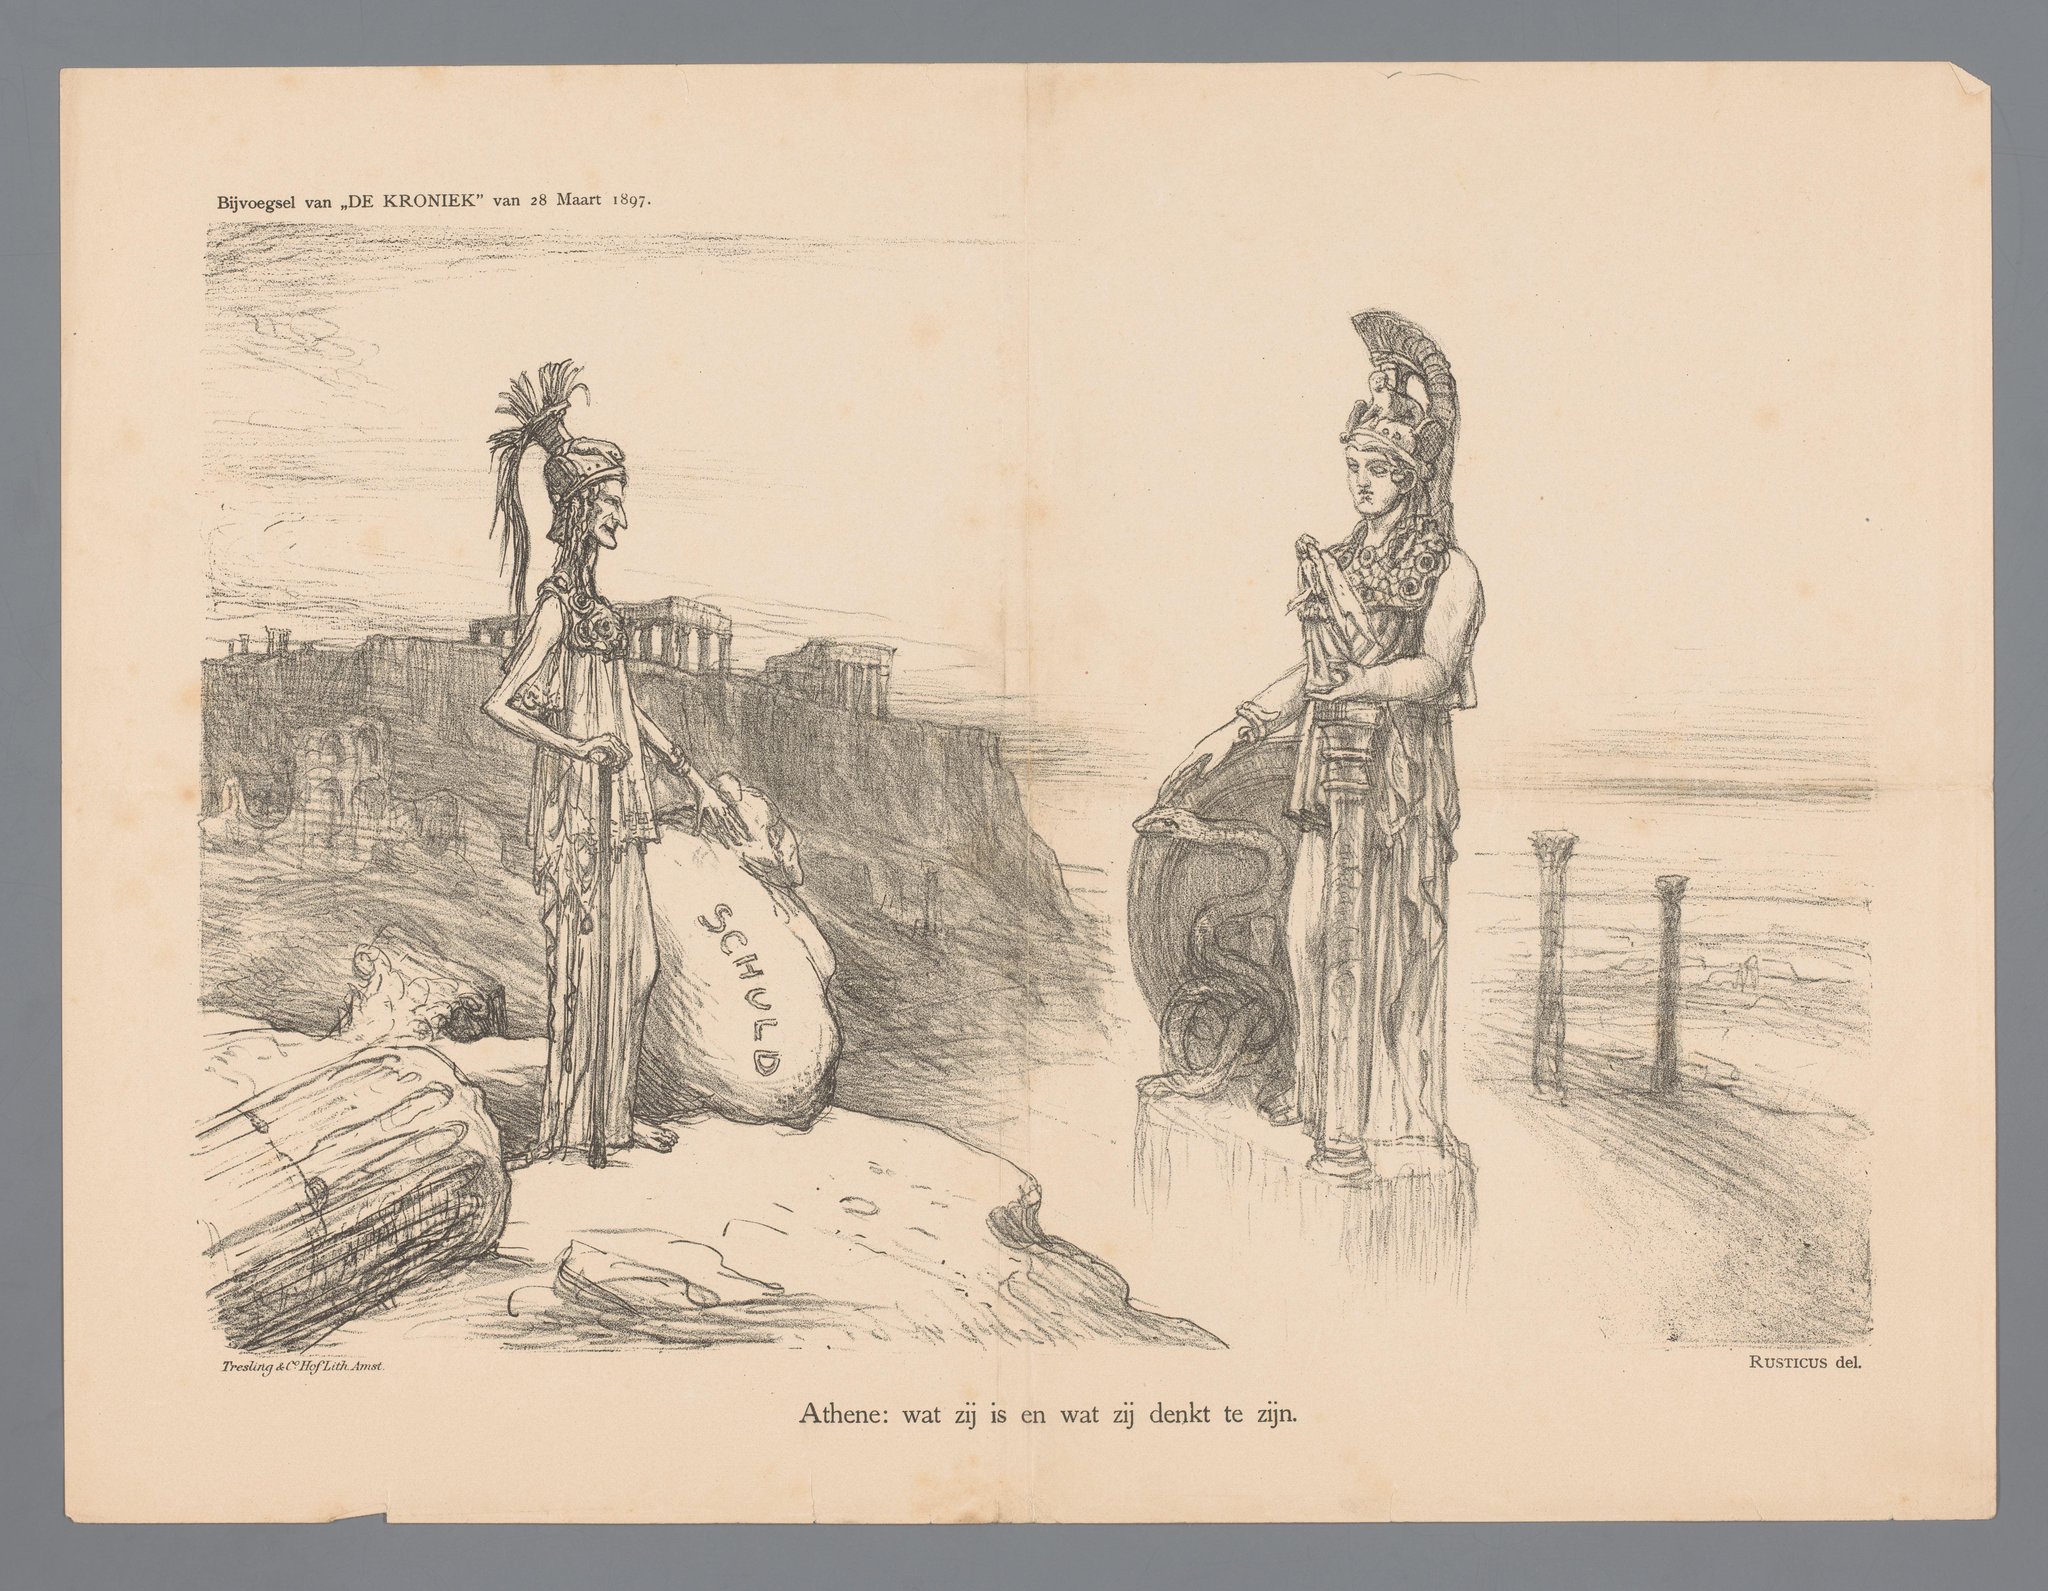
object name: cartoon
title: Athene: wat zij is en wat zij denkt te zijn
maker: marius bauer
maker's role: draughtsman, print maker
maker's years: 1867-1932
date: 1897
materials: paper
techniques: lithograph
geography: amsterdam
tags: (story of) minerva (pallas, athena), temple, shrine ~ roman religion, personifications of countries, nations, states, districts, etc. (+ nation; national), coastal cliff or crag, political caricatures and satires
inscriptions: date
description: Spotprent op de zwakke positie van Griekenland in 1897 ten tijde van de opstand op Kreta tegen de Turken. Personificatie van Griekenland, links zoals zij werkelijk is: mager en beladen met schulden, rechts zoals zij zichzelf ziet: jong en krachtig. Verschenen in de bijvoegsel van 'De Kroniek' van 28 maart 1897.